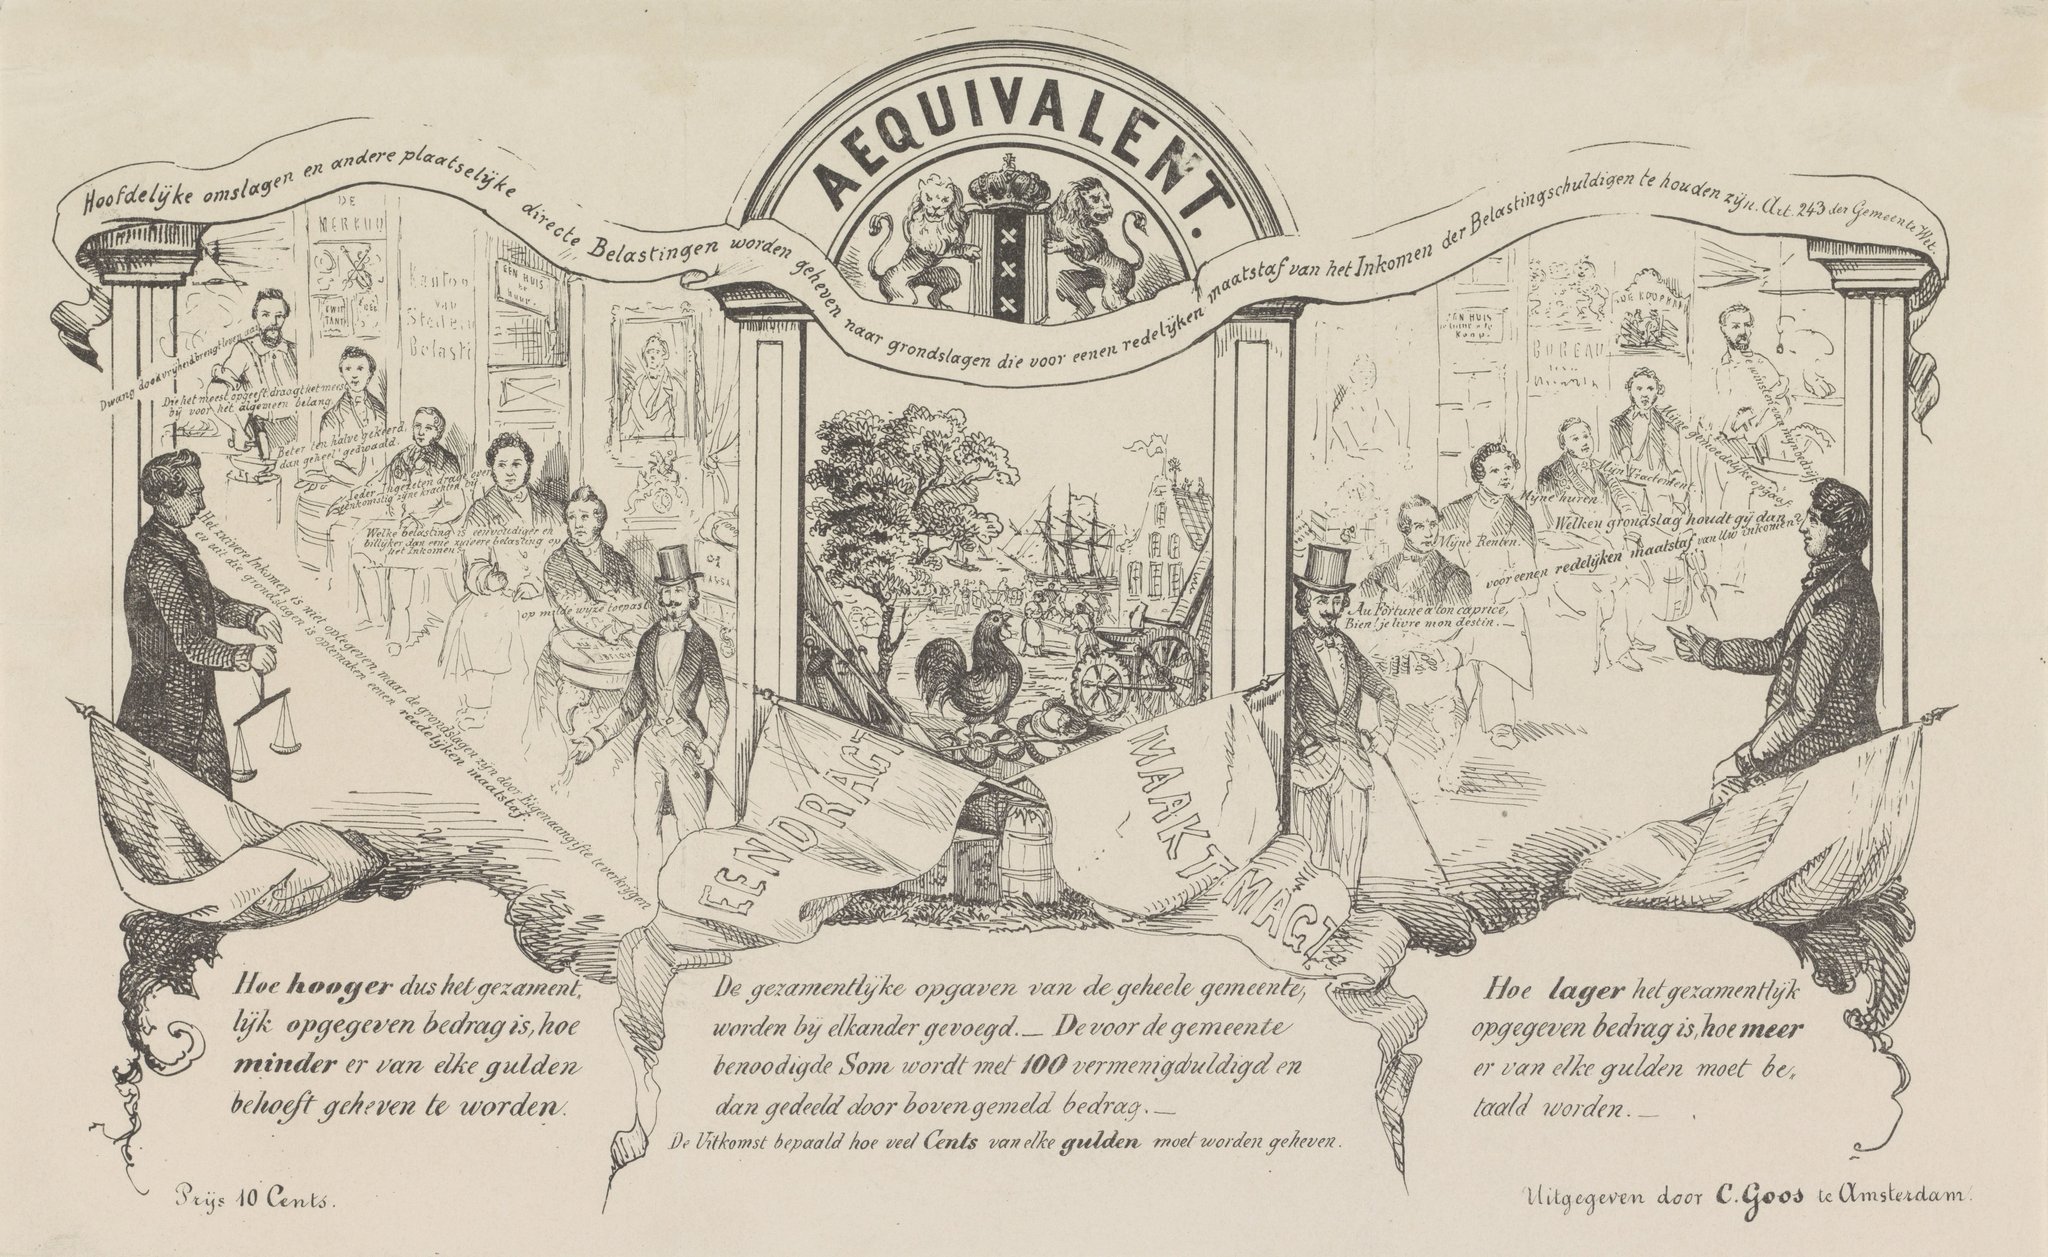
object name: print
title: Aequivalent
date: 1856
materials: paper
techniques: lithograph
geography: amsterdam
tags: tax payment, amsterdam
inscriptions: collector's mark: Lugt 2228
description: Spotprent op een nieuwe belasting volgens de vertering, ingevoerd te Amsterdam, 14 maart 1856. Centraal een emblematische bloeiende handelsstad met attributen van de handel, vaandels en een kraaiende haan. Ter weerszijden twee rijen belastingbetalers die hun mening geven over de inkomstenbelasting. Bovenaan het stadswapen van Amsterdam.